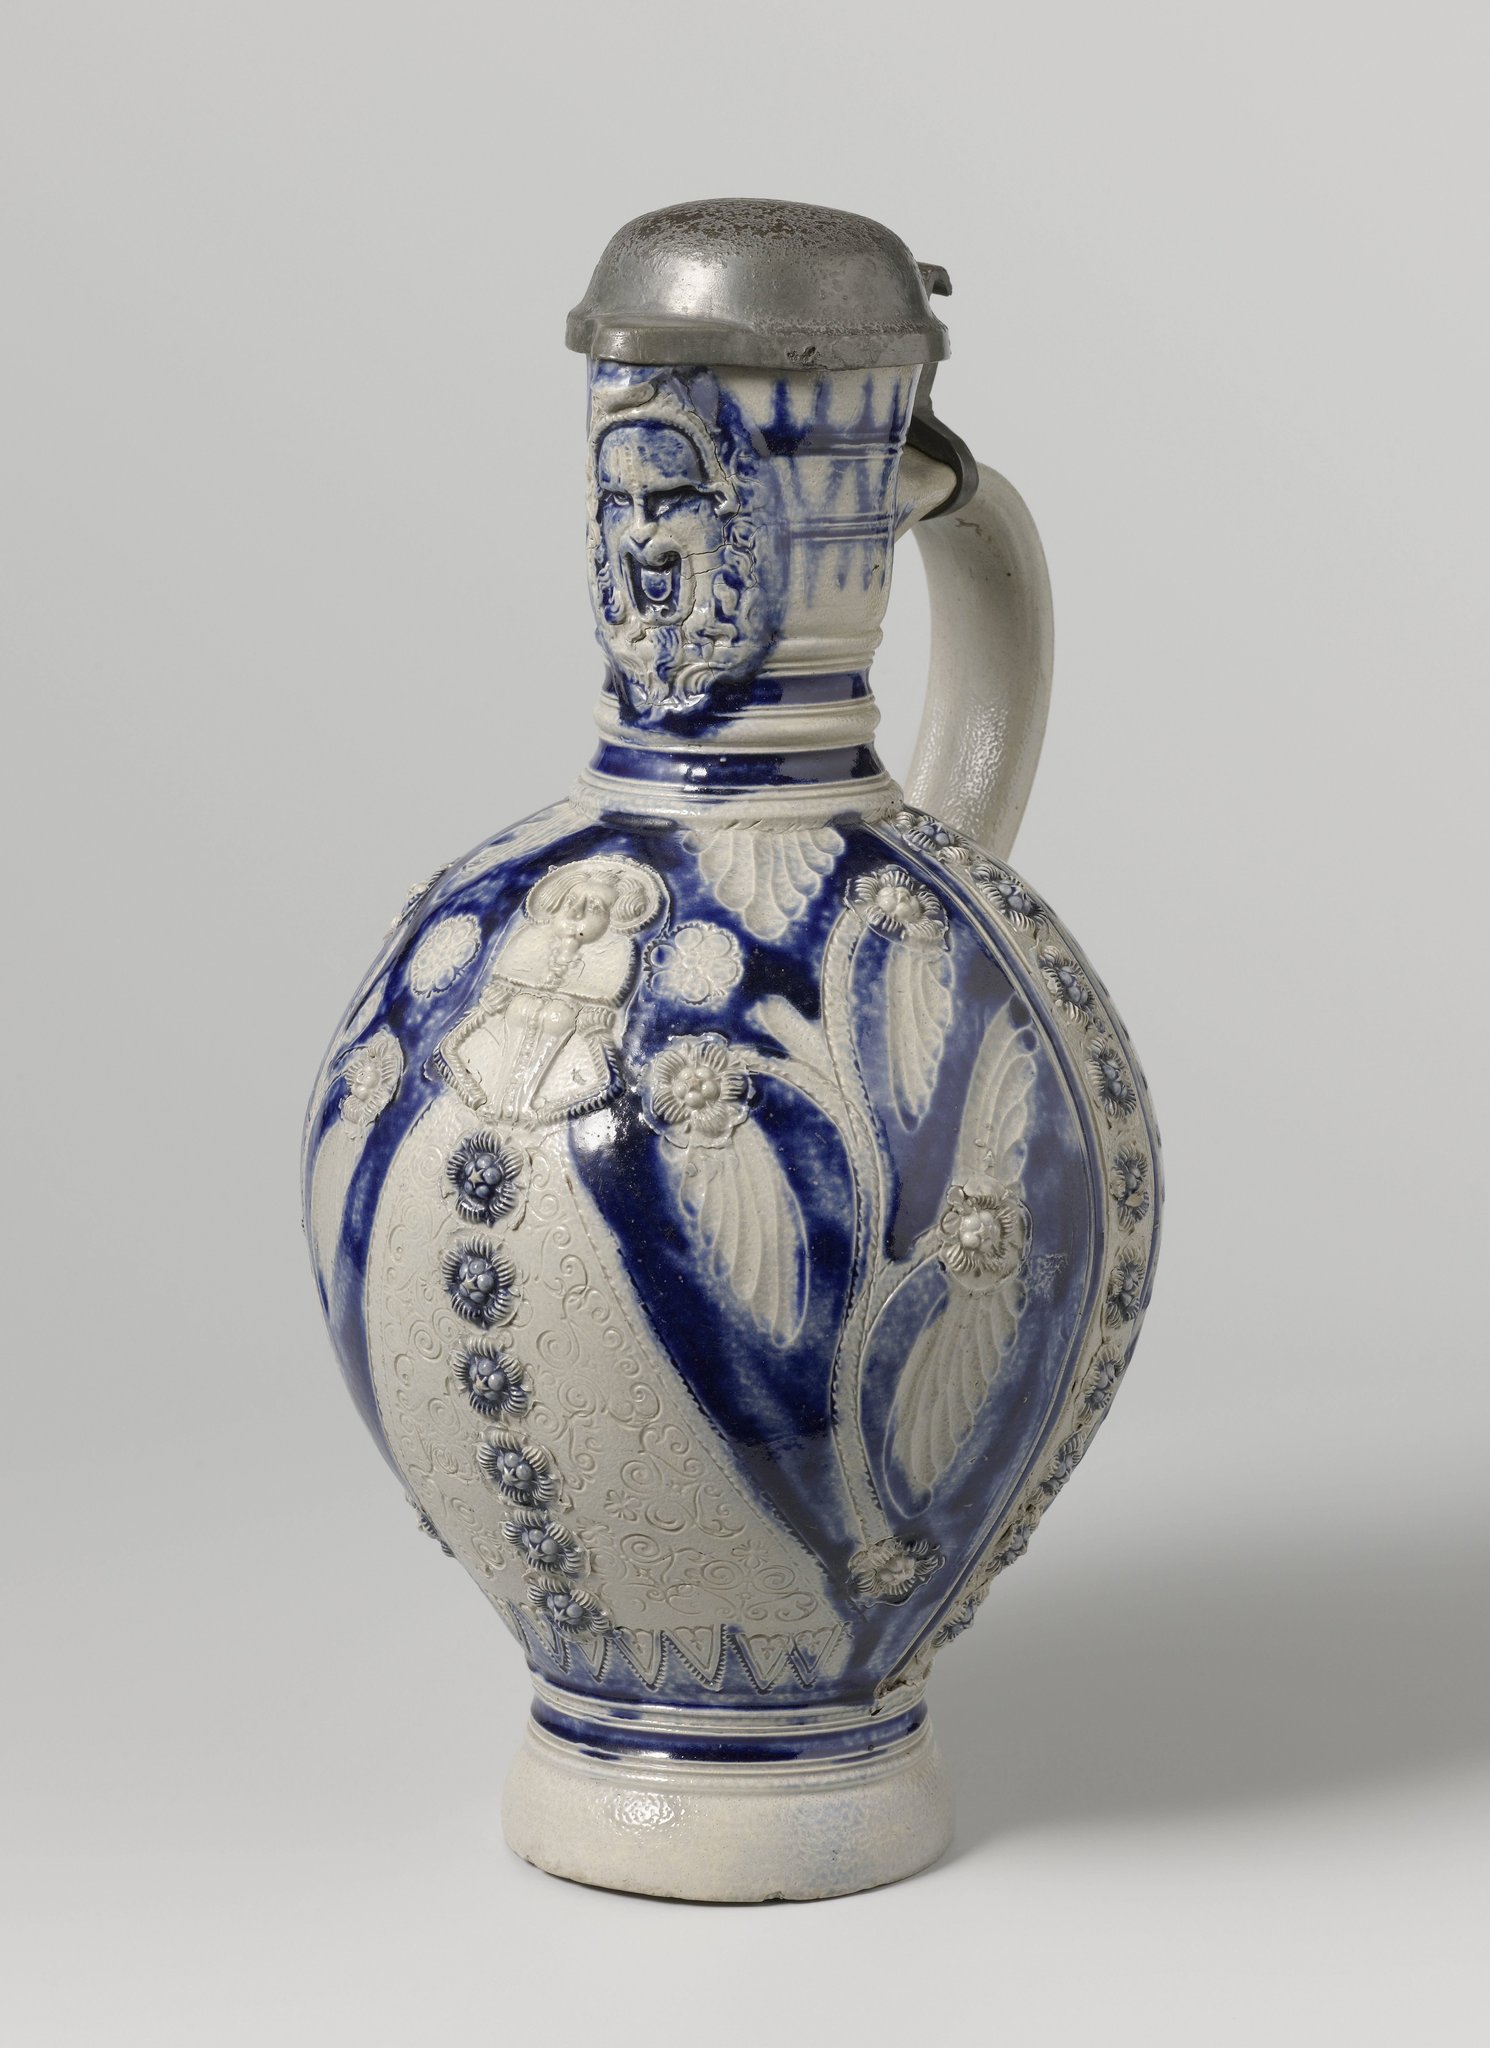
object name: ewer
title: Jug with a lady among floral scrolls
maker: Anonymous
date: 1670-1680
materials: cobalt, glaze, stoneware, tin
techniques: firing, forming, relief, turning, vitrification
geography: westerwald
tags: mask, mascaron ~ ornament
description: Kan van steengoed op hoge voet met een smalle nek, eivormig lichaam en in de rand een geknepen tuit. Het C-vormige oor is bevestigd aan de nek en de schouder. Gedeeltelijk bedekt met kobaltblauw. Op de voet en de nek enkele profielen. Op de buik een gedrukte en opgelegde dame met een ingegrifte rok met rozetten in reliëf. Aan weerszijden hiervan ingegrifte bloemranken, waarvan de bloemen in reliëf zijn. Aan weerszijden van deze decoratie een verticale van opgelegde rozetten. Op de nek onder de tuit is een gemodelleerde leeuwenkop aangebracht. Bevestigd aan het oor een tinnen montuur met deksel. Westerwald.